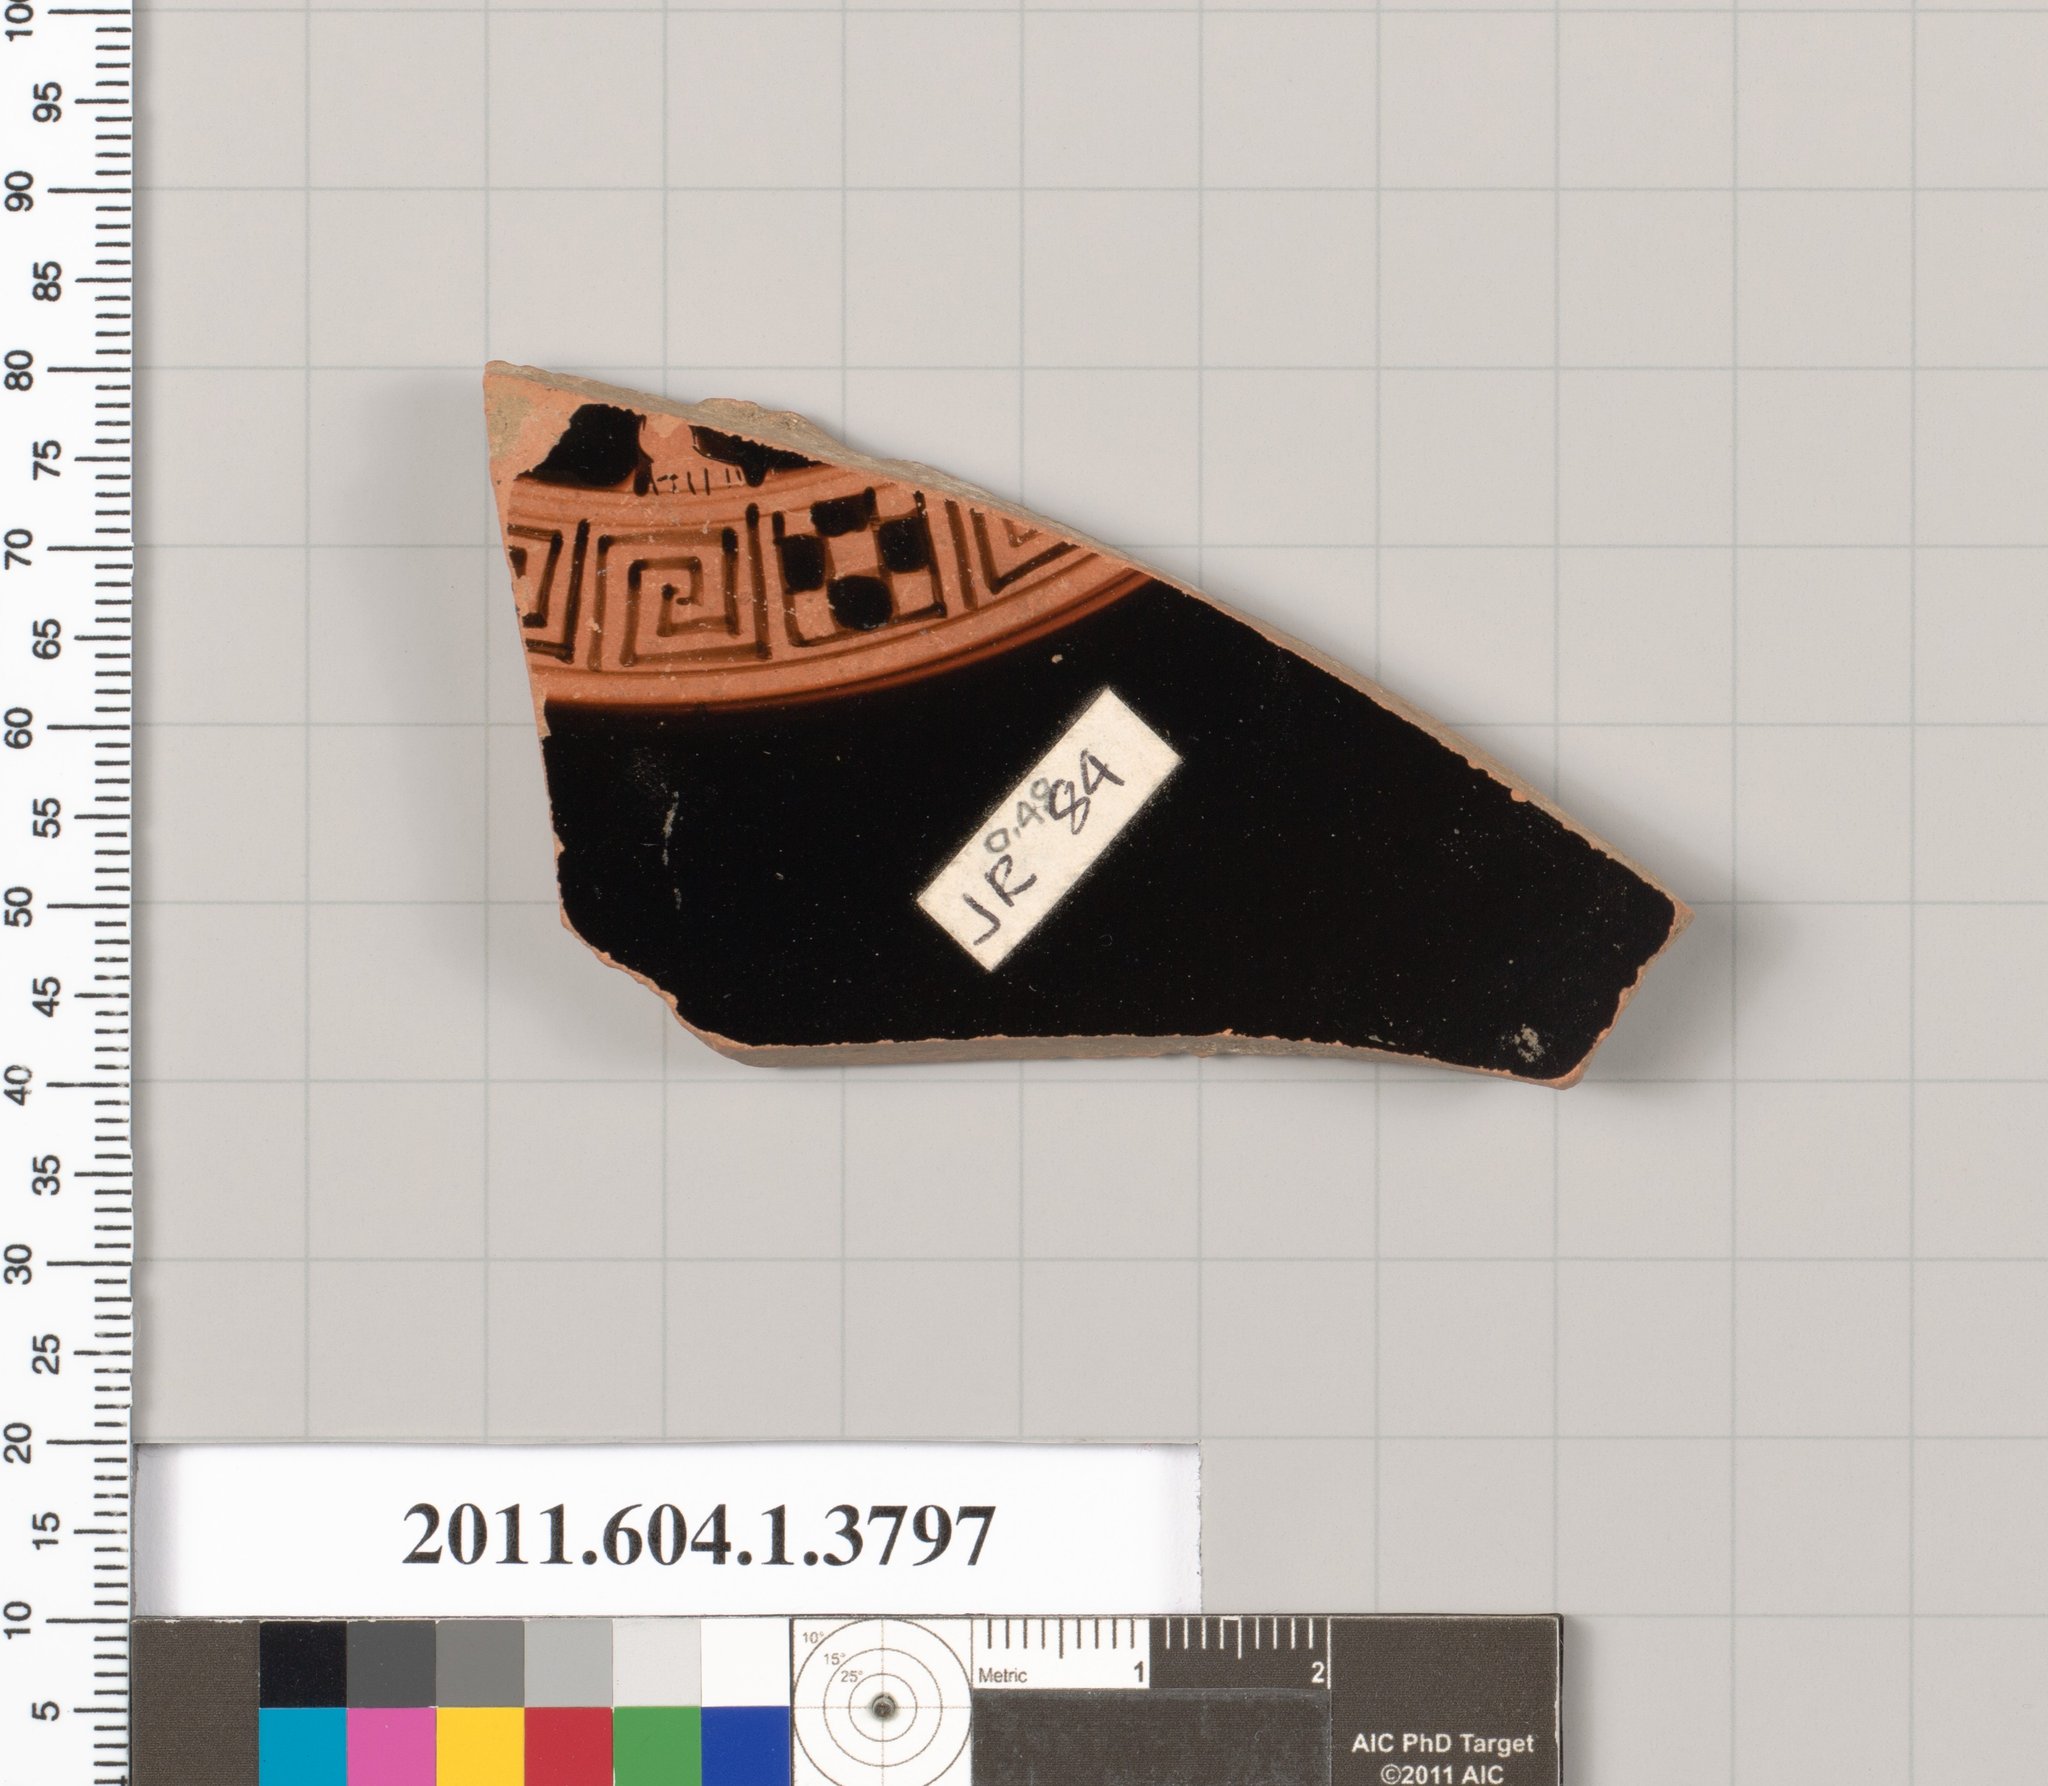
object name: kylix fragment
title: Terracotta fragment of a kylix (drinking cup)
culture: greek, attic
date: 475-451 BCE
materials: terracotta